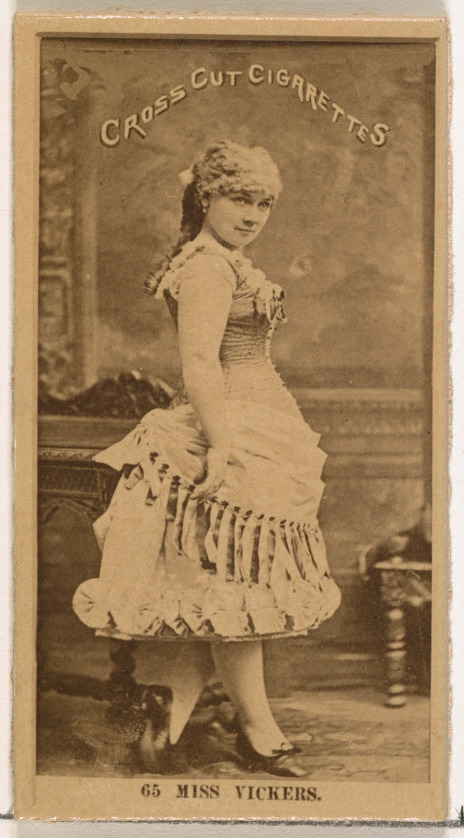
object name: print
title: Card Number 65, Miss Mattie Vickers, from the Actors and Actresses series (N145-2) issued by Duke Sons & Co. to promote Cross Cut Cigarettes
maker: w. duke, sons & co.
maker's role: publisher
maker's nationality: american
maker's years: 1870-1920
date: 1880-1889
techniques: albumen silver print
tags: portraits,women,actresses